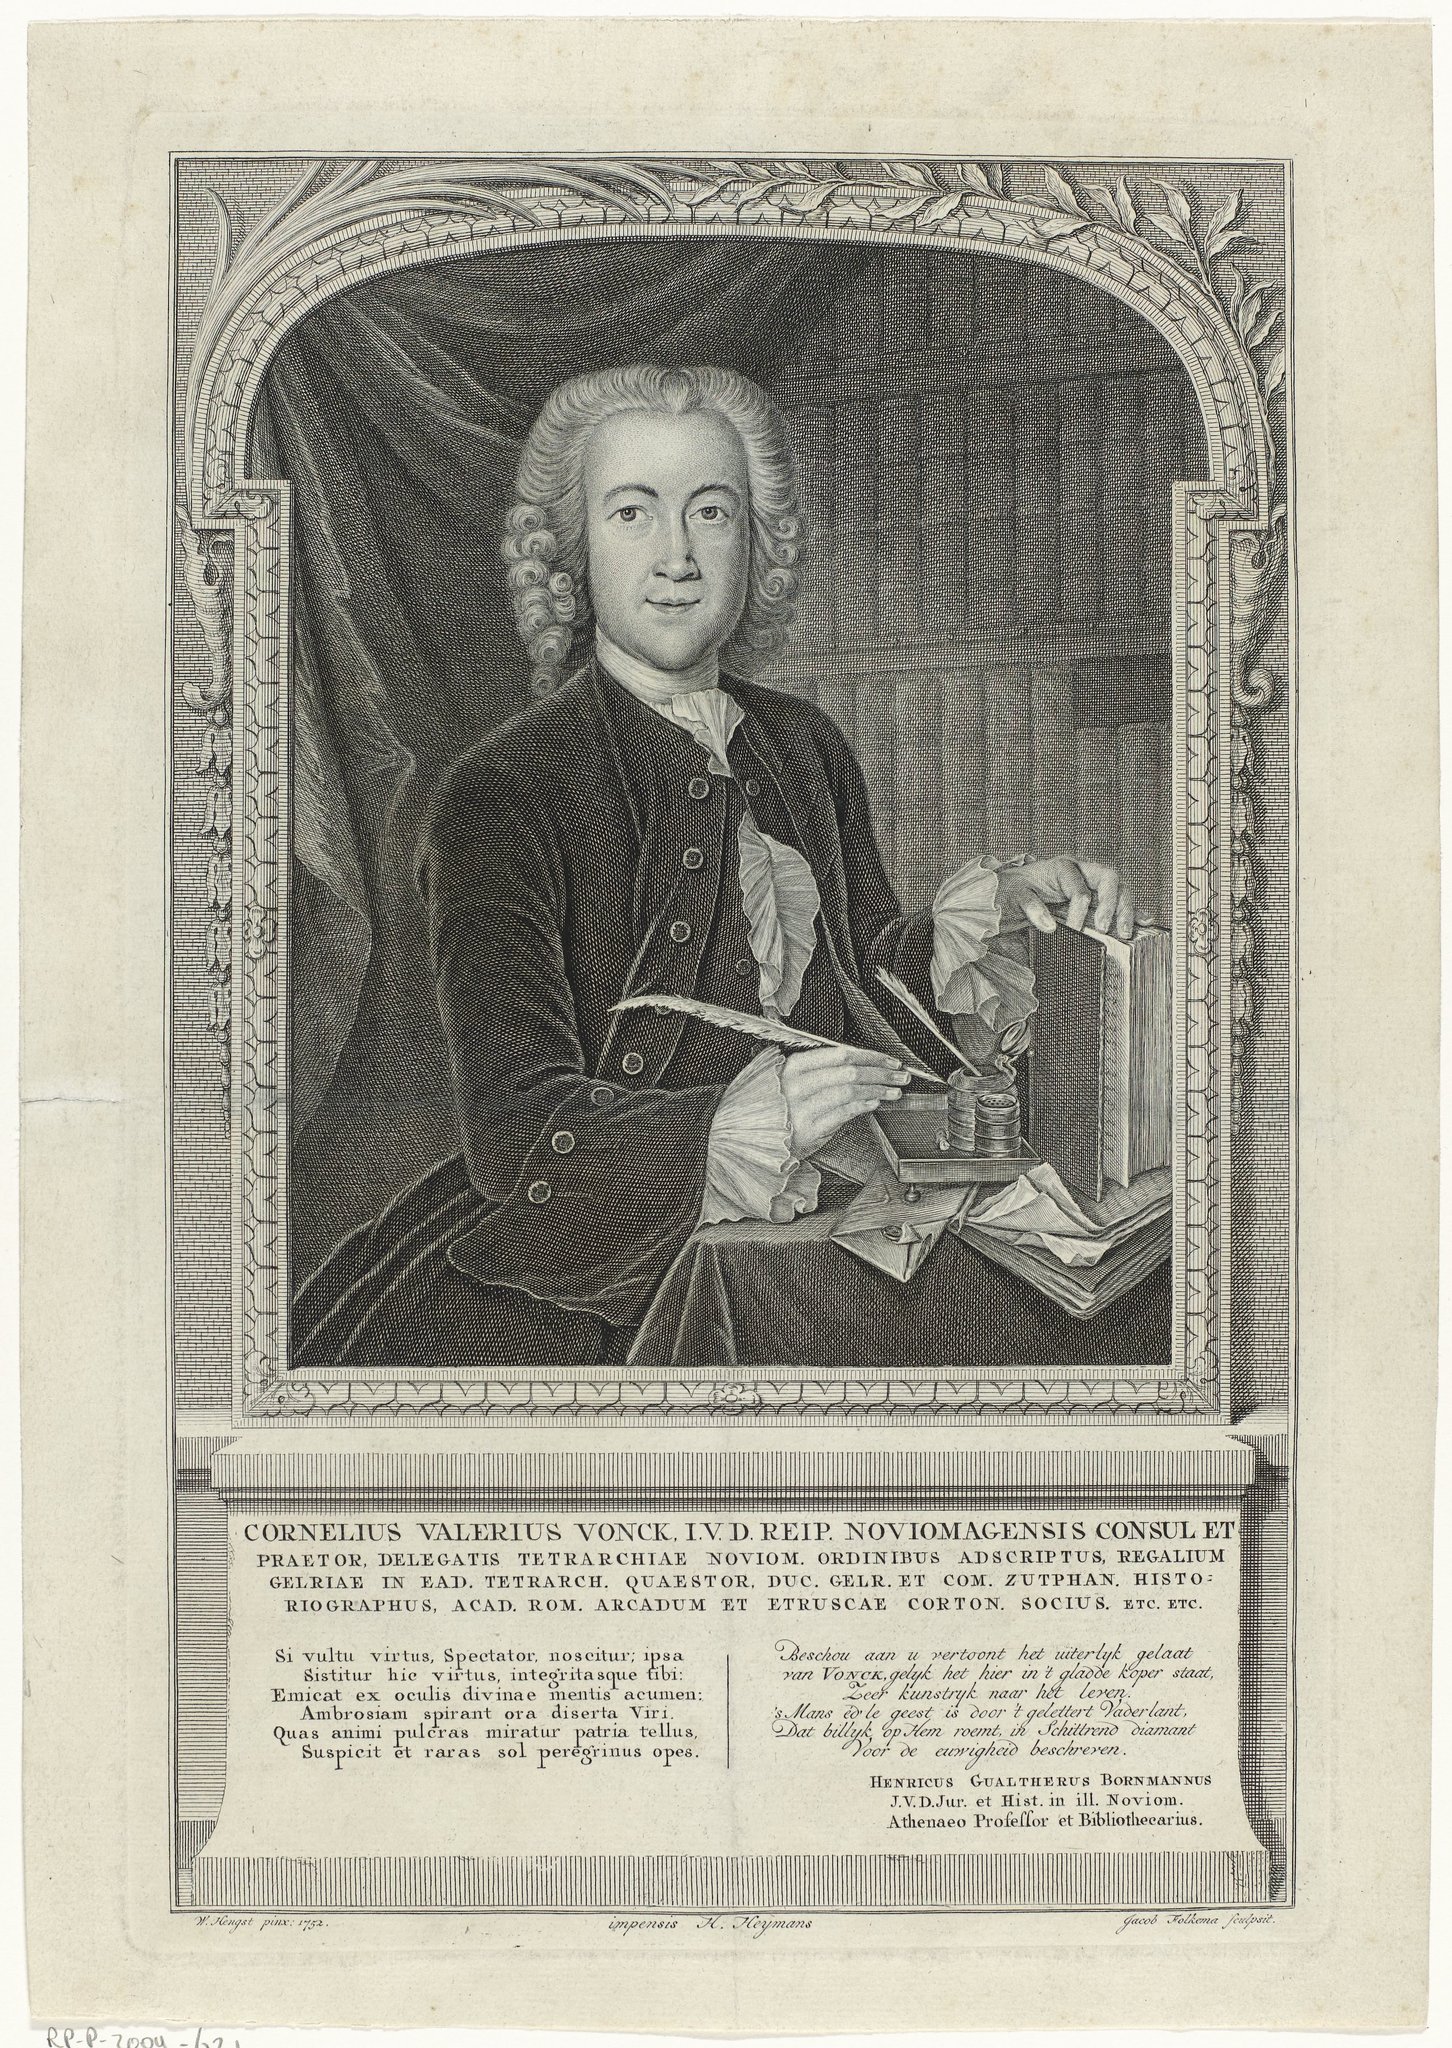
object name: print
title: Portret Cornelius Valerius Vonck, burgemeester van Nijmegen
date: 1752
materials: paper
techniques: engraving, etching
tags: nijmegen, ink-well, study; 'studiolo'; library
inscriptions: date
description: Portret ten halven lijve van Cornelius Valerius Vonck, burgemeester van Nijmegen. In zijn rechterhand een schrijfveer, zijn linkerhand rust op een boek. Op de achtergrond een gordijn en een boekenkast. Onder het portret staan op een sokkel in het Latijn de naam en titels van de geportretteerde, gevolgd door een tekst in Latijn en Nederlands.